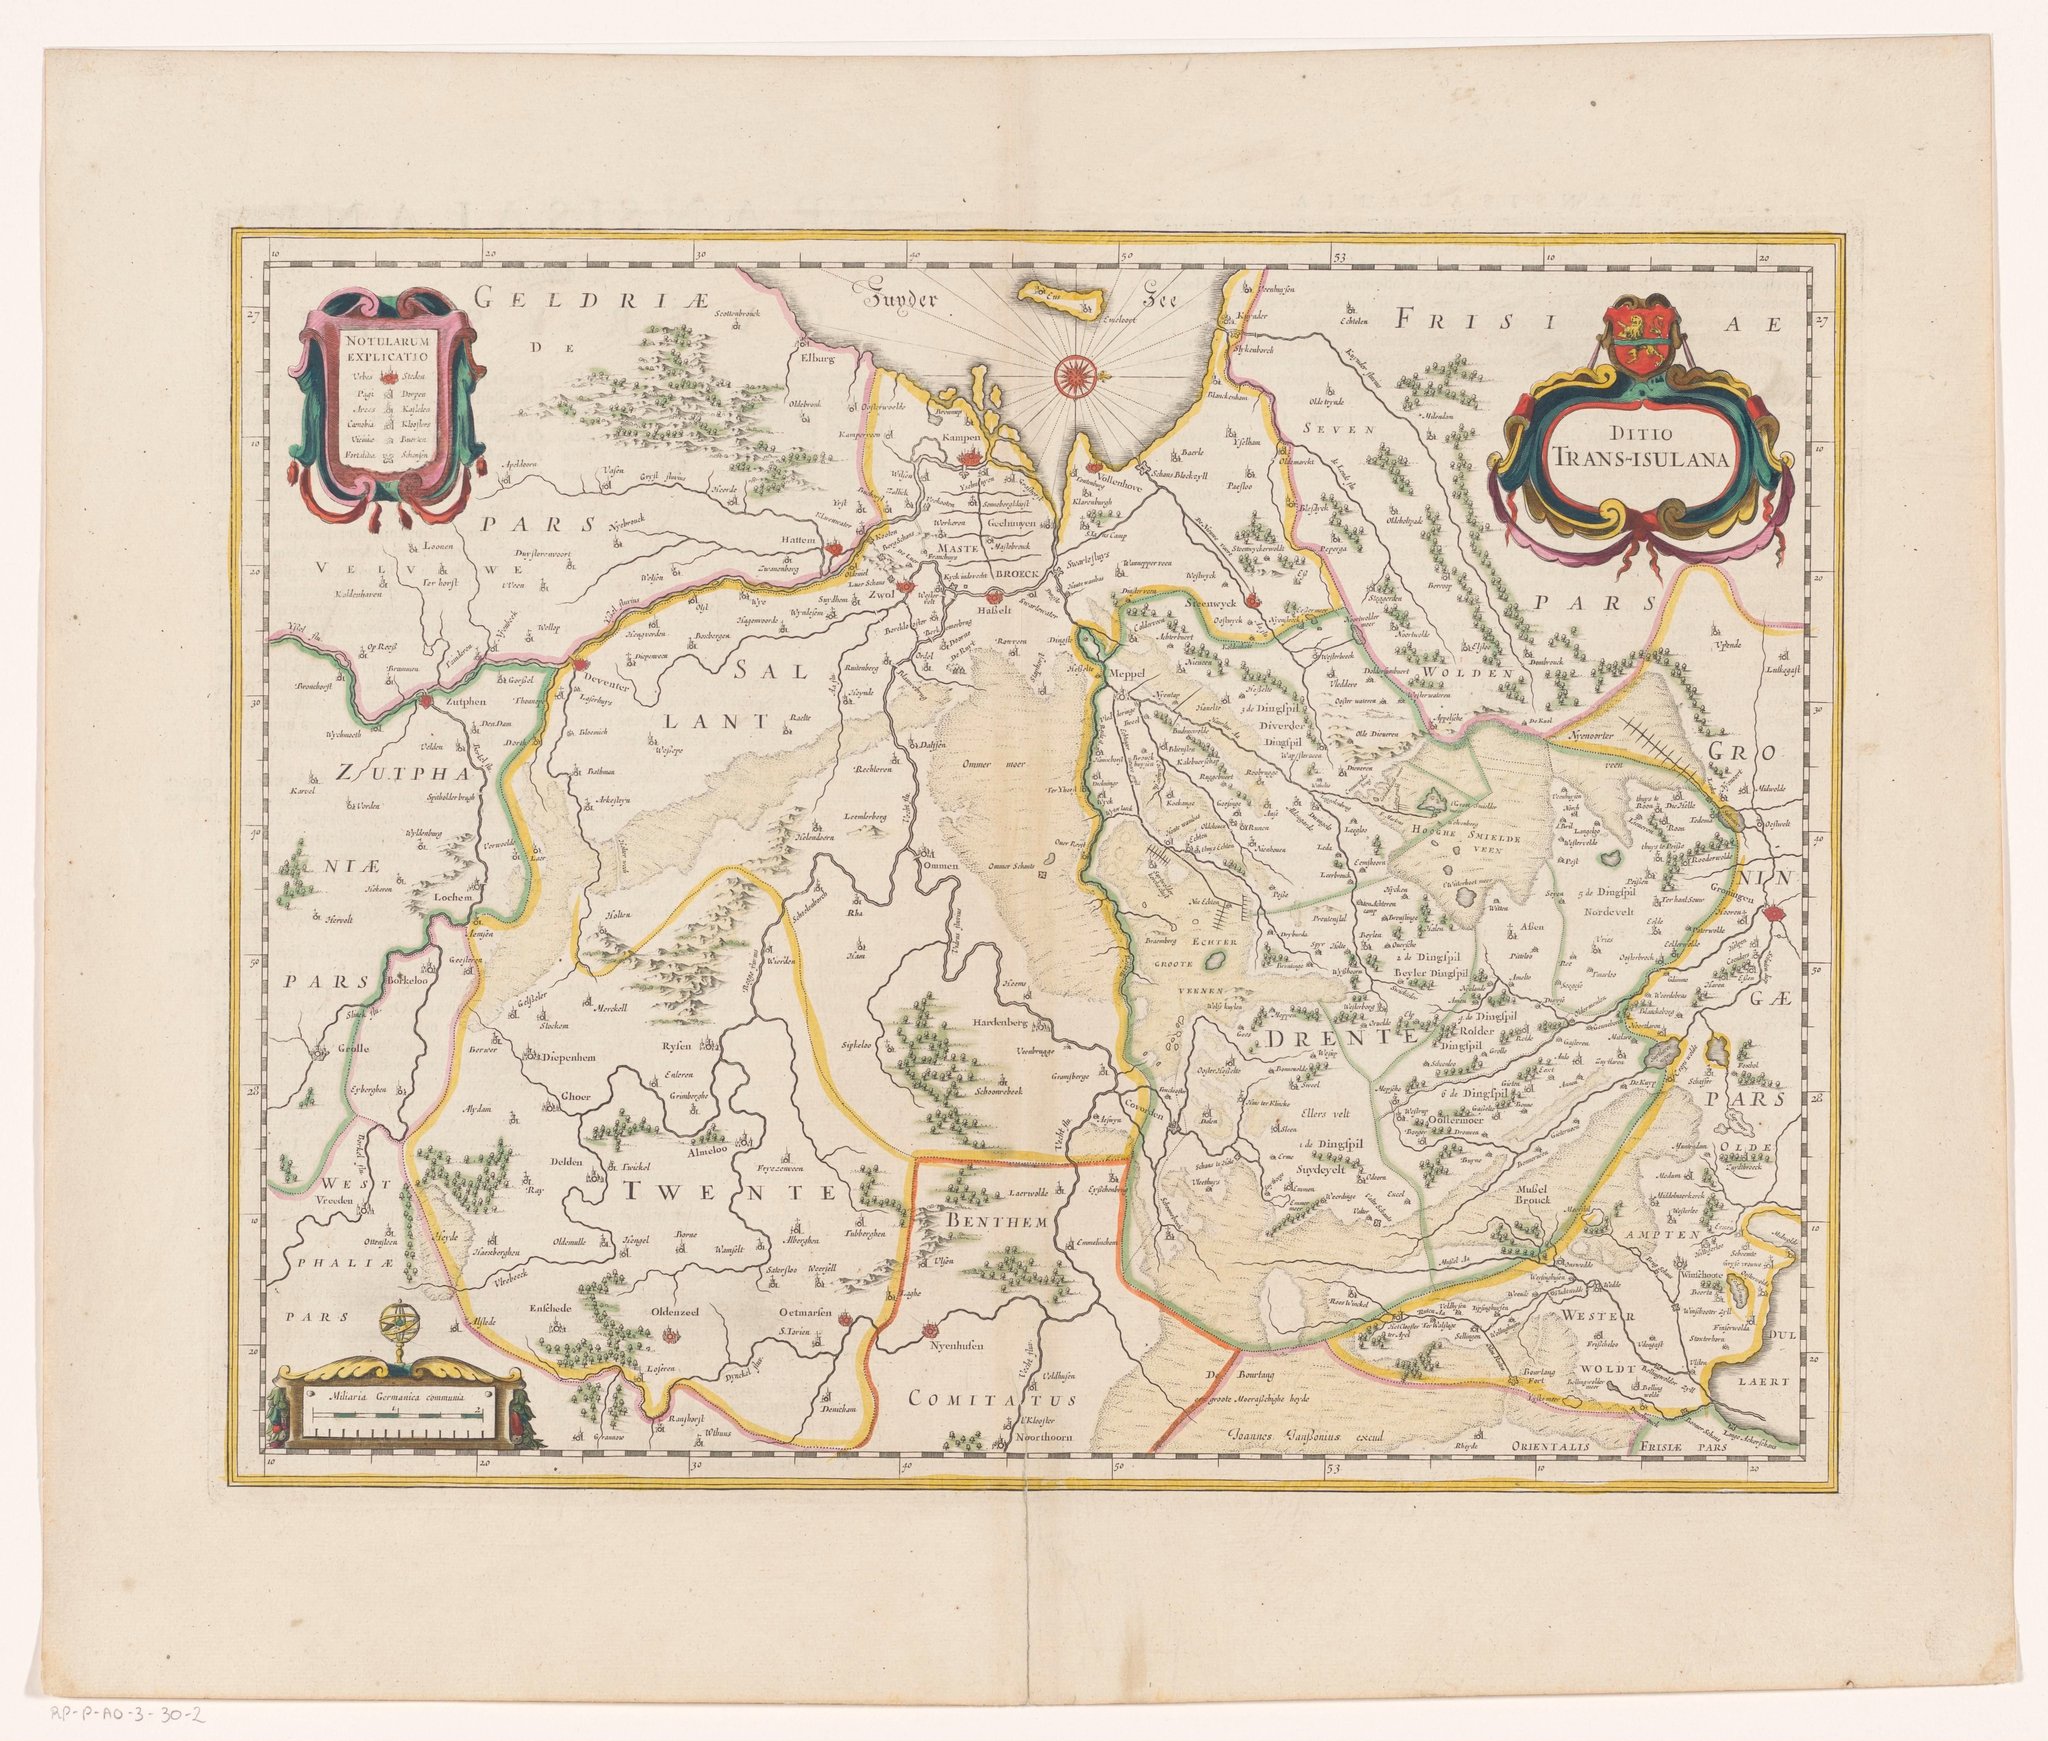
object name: map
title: Ditio Trans-isulana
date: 1653-1666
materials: paper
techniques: engraving, letterpress printing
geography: amsterdam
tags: coat of arms (as symbol of the state, etc.), maps of separate countries or regions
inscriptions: collector's mark: Lugt 195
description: Linksboven legenda, linksonder een schaalstok: Milliaria Germanica communia. Rechtsboven cartouche met titel en het wapen van Overijssel. Gradenverdeling langs de randen. Op verso Spaanse tekst